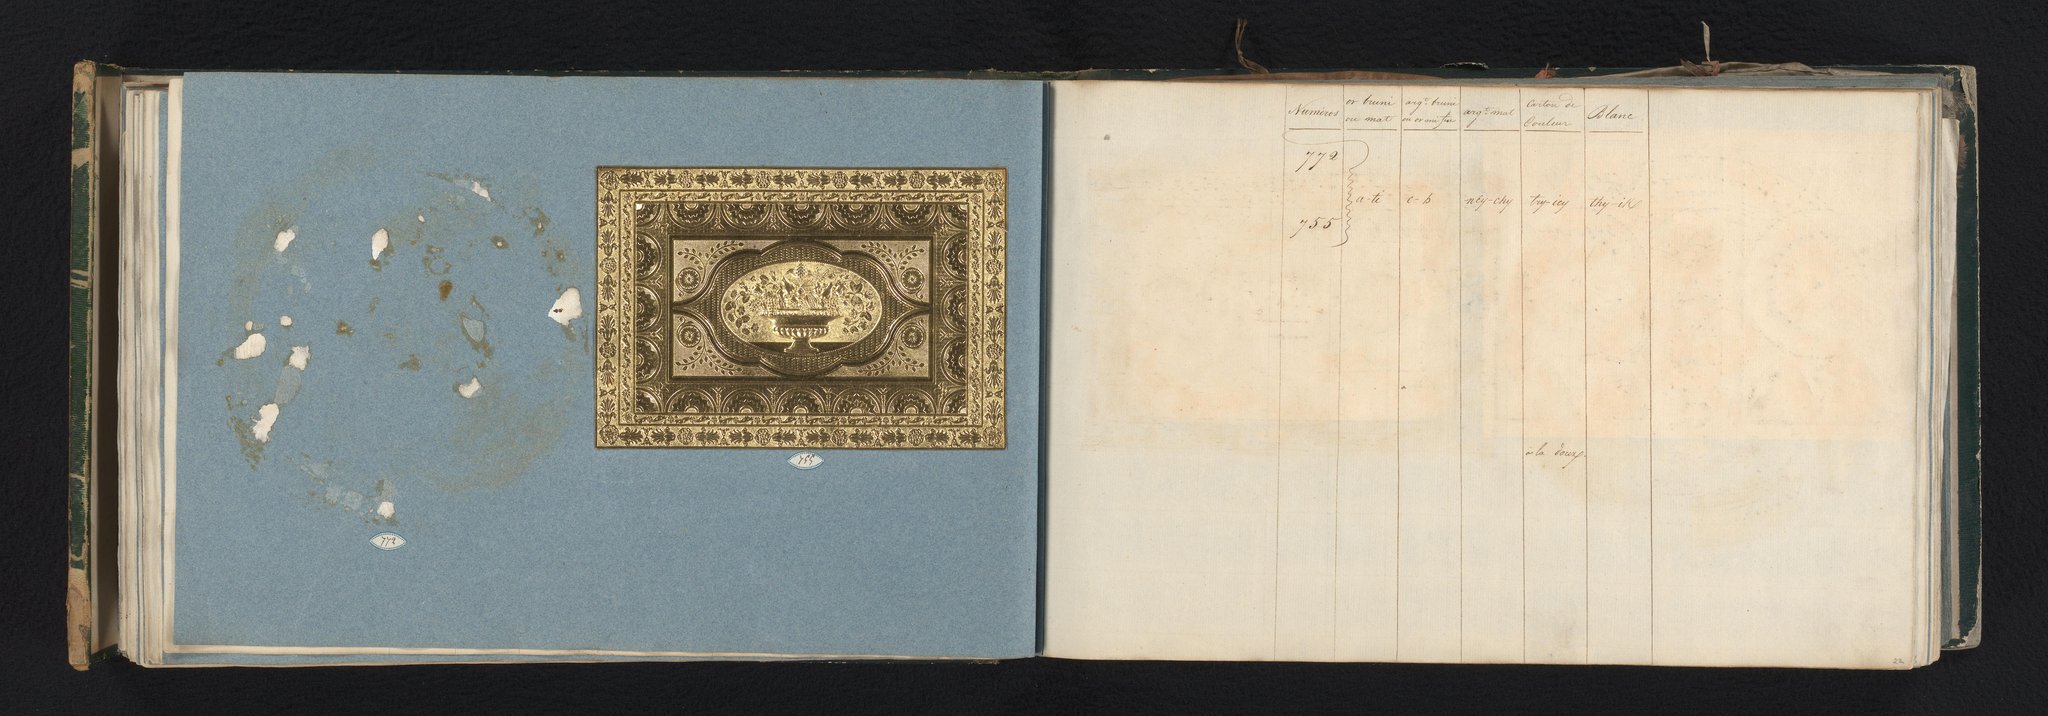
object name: sample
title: Twee bladzijden met staal van vignet van goudkleurig metaalpapier en bijbehorend tabel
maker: Anonymous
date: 1830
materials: gold leaf, ink, paper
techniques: manufacturing, writing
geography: france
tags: ornaments ~ art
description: Twee bladzijden met links één opgeplakte en met etiket genummerde (755) staal van een decoratief vignet van goudkleurig metaalpapier (staal nr. 772 ontbreekt). Op de tegenoverliggende rechterbladzijde een tabel met de handgeschreven corresponderende specificaties (in code) per ornament. Onderdeel van het stalenboek geschonken door de dames Van Rijn, vermoedelijk van een Franse papierfabrikant van luxe papieren, of diens vertegenwoordiger in Nederland, ca. 1830.